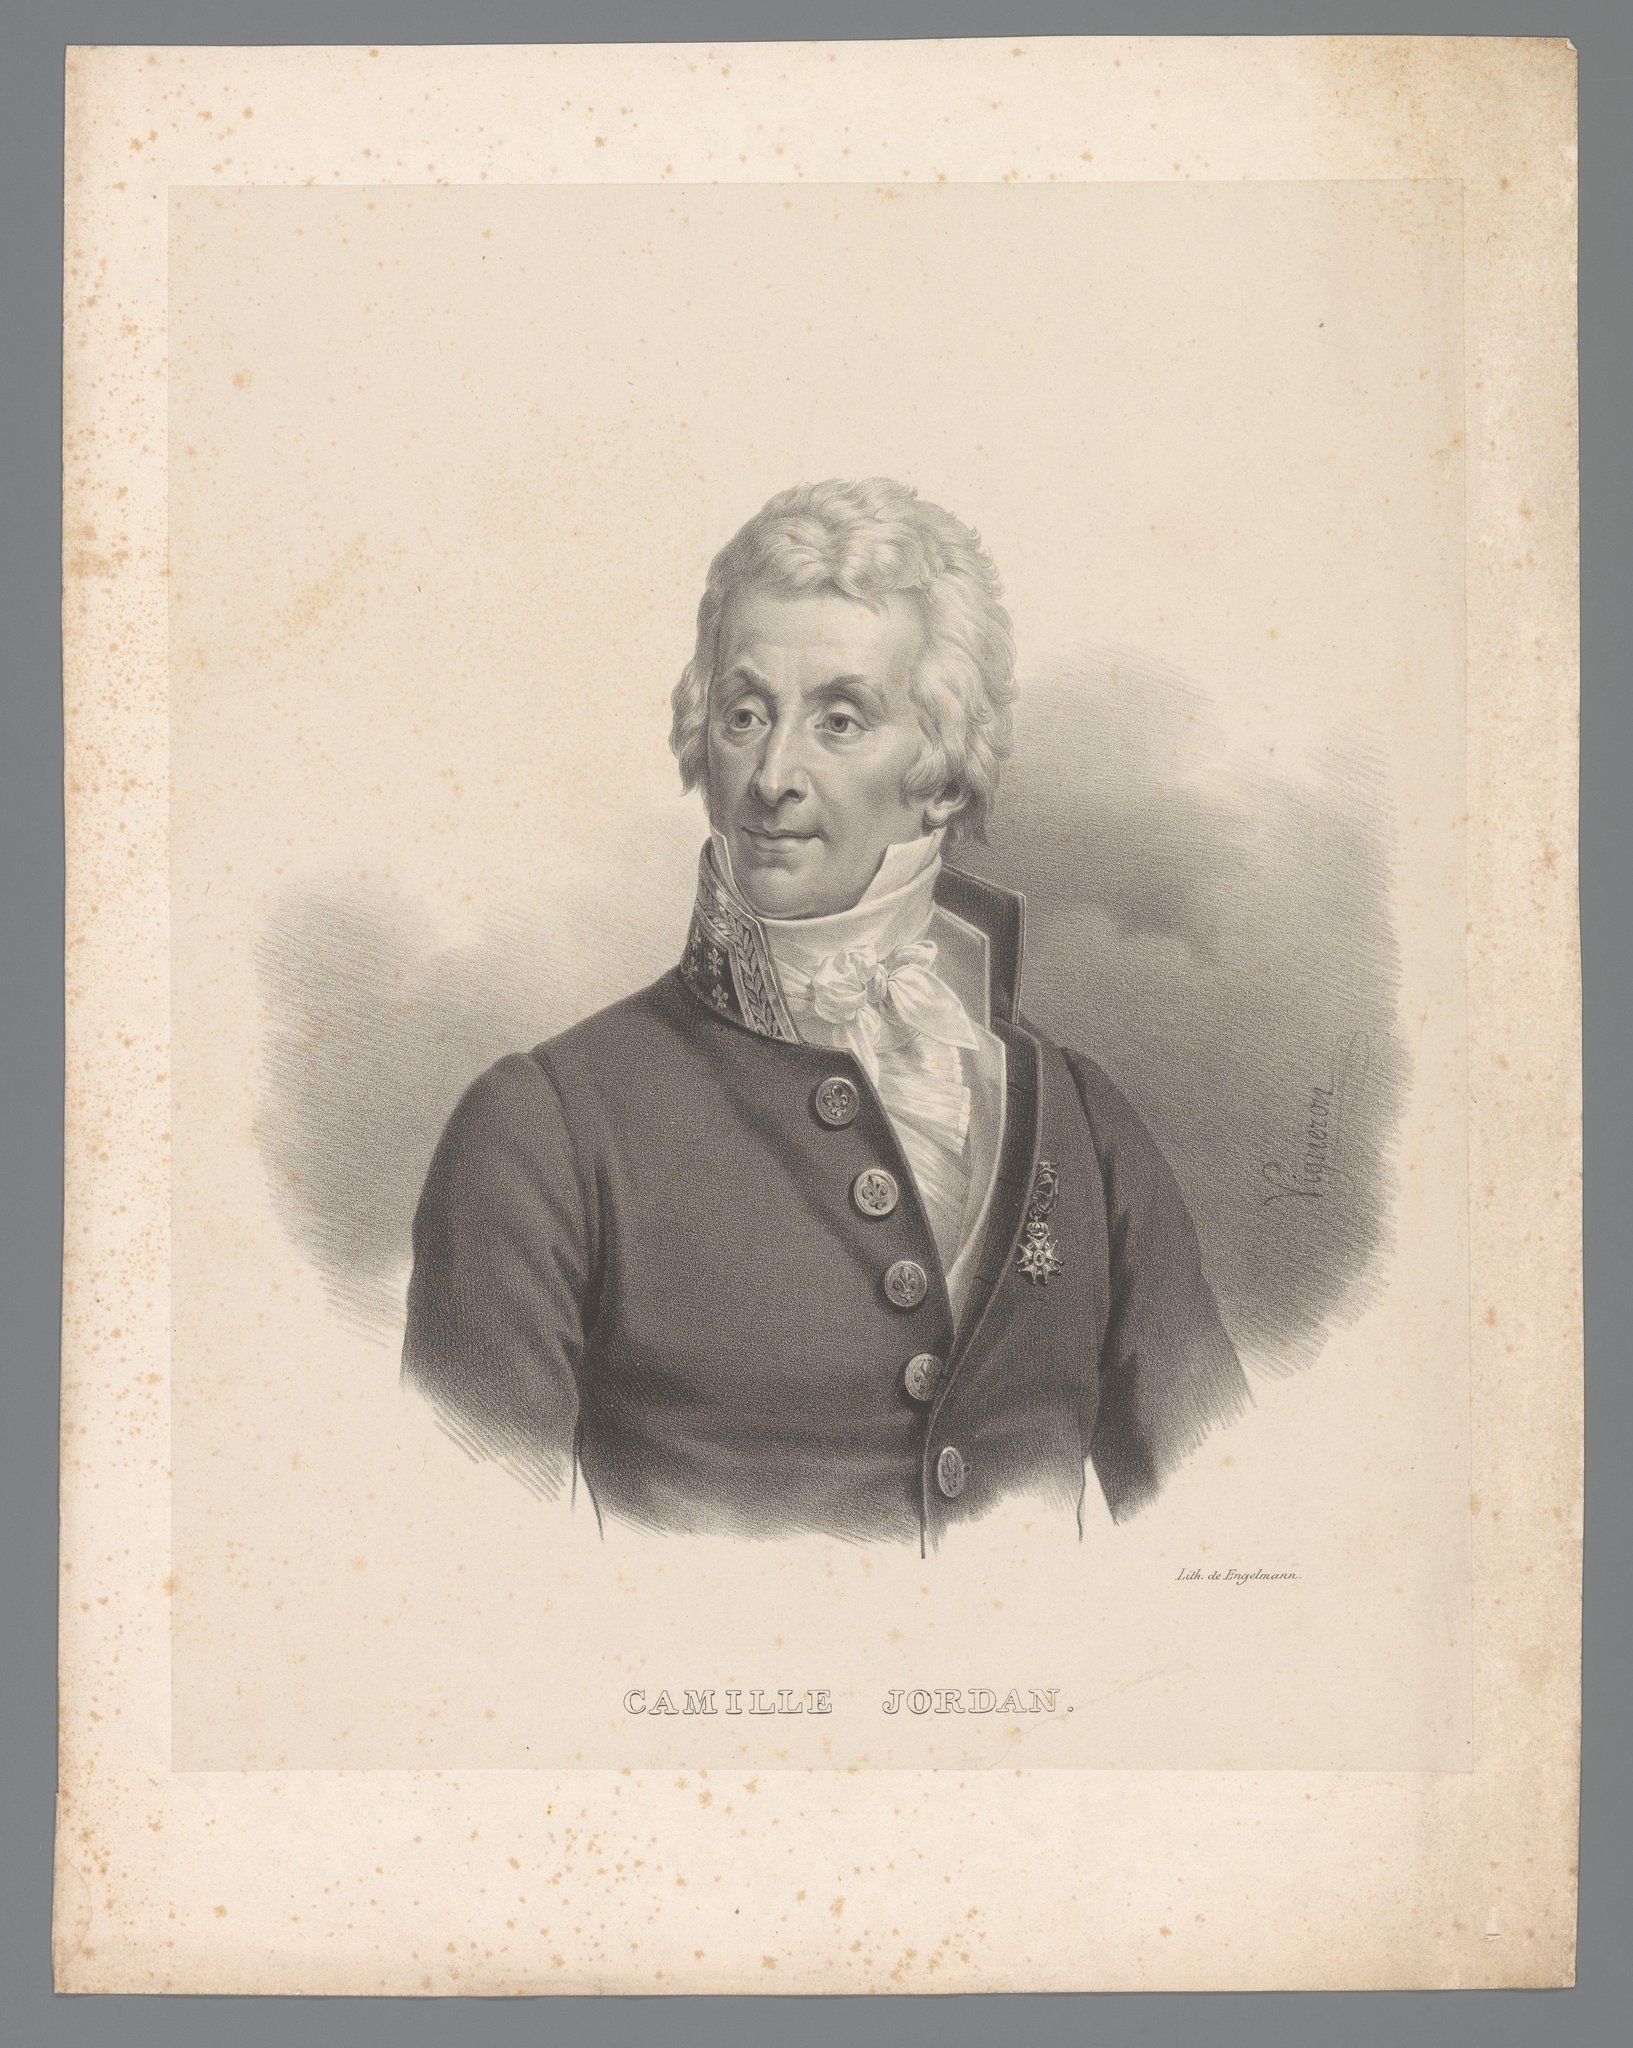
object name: print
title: Portret van Camille Jordan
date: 1826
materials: paper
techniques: lithograph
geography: paris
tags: lyon, paris, politician, historical persons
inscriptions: collector's mark: Lugt 2228